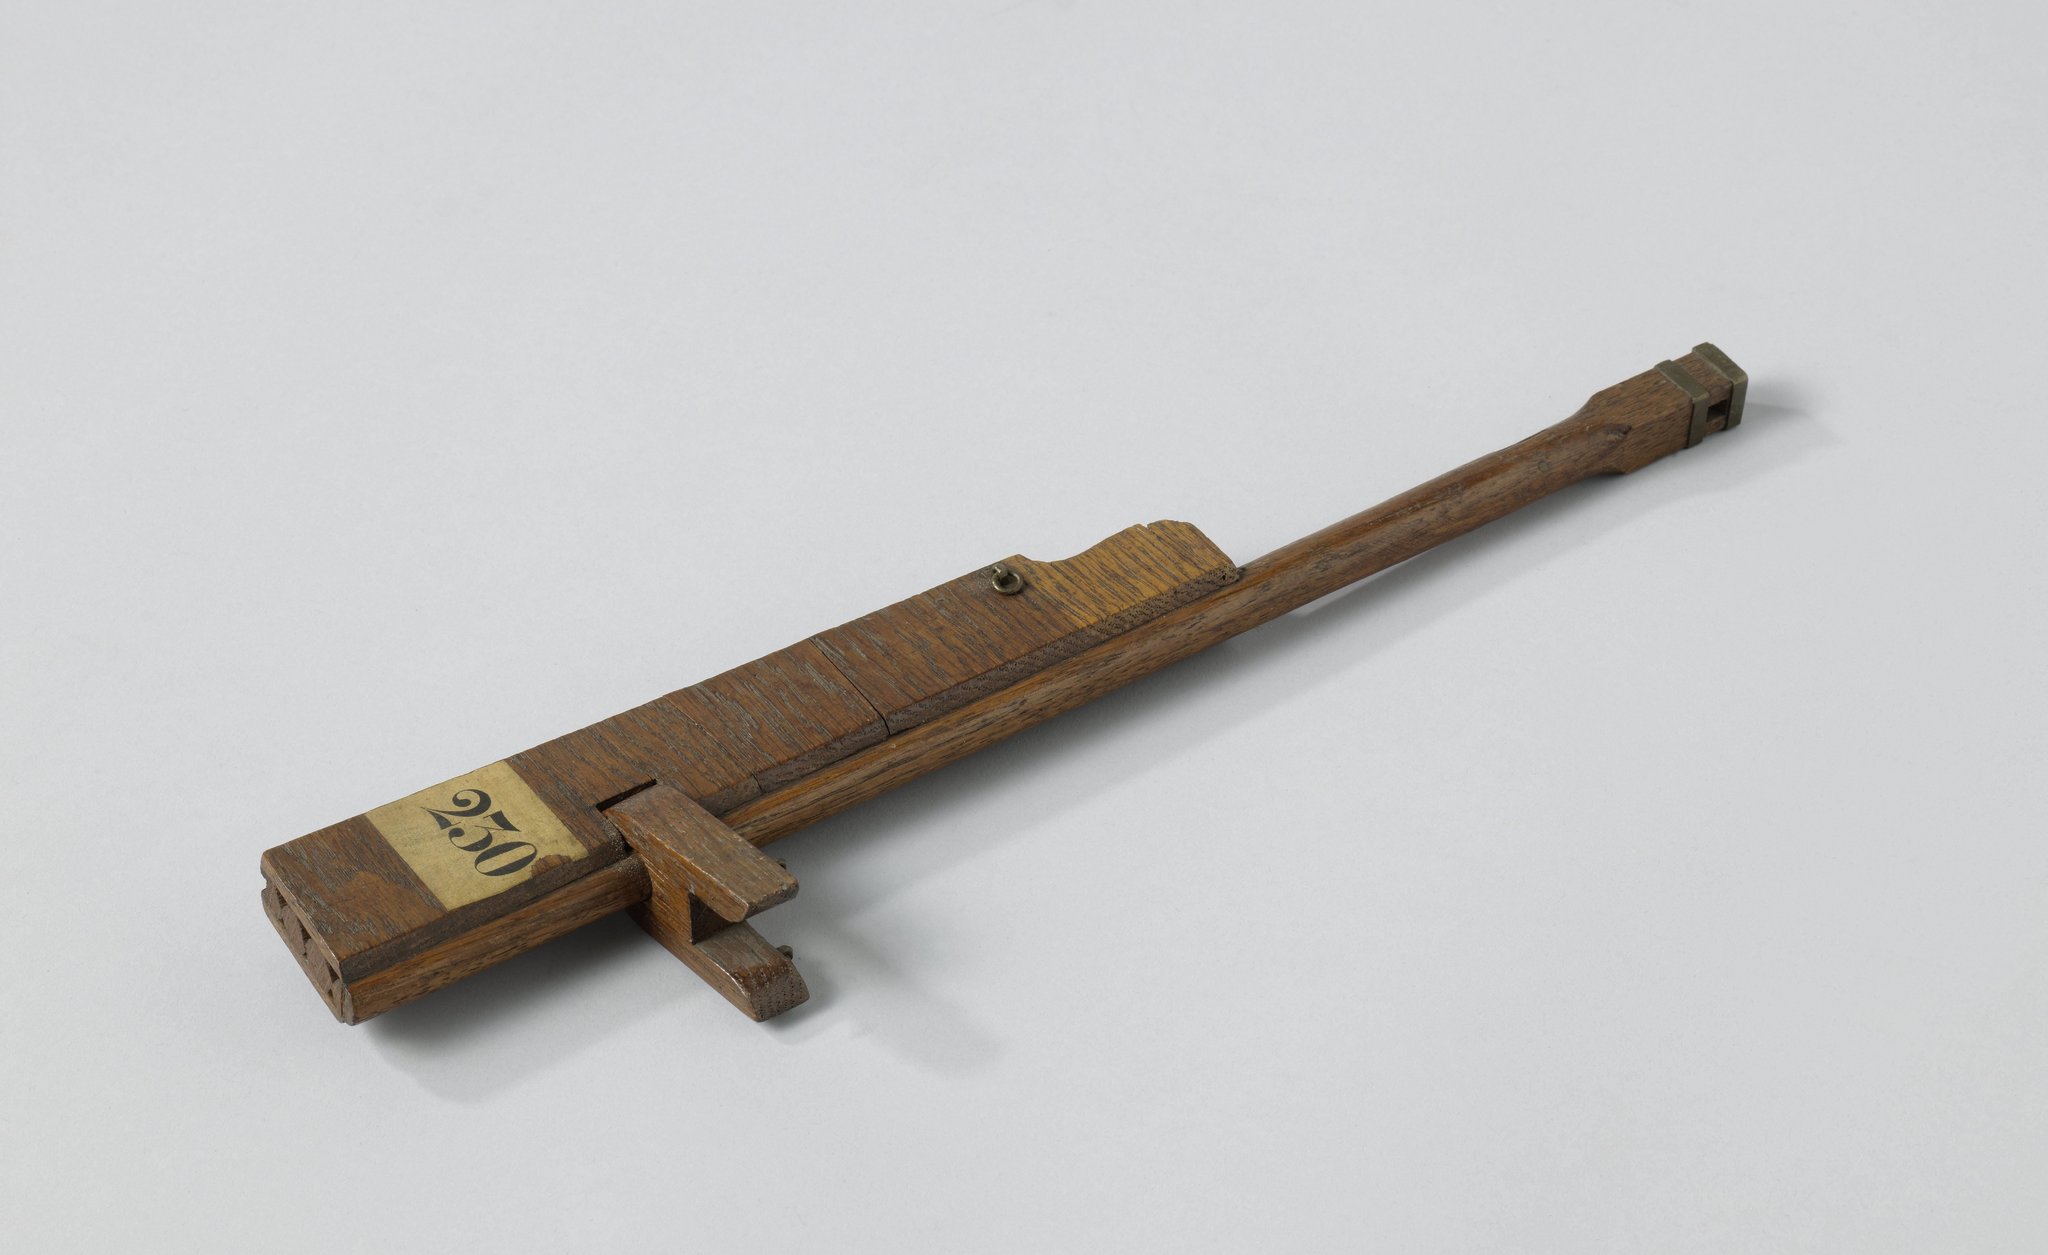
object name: demonstration model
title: Model of a Jury Rudder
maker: Anonymous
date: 1800-1850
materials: brass, wood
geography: netherlands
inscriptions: label, bottom: ‘230’ former inventory label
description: Model van een noodroer met een steng als koning. Het blad is samengesteld uit rondhouten met planken bedekt (waaronder de oren van een mast), en een ezelshoofd als roerhaak om de koning. Dit model is identiek aan NG-MC-228.